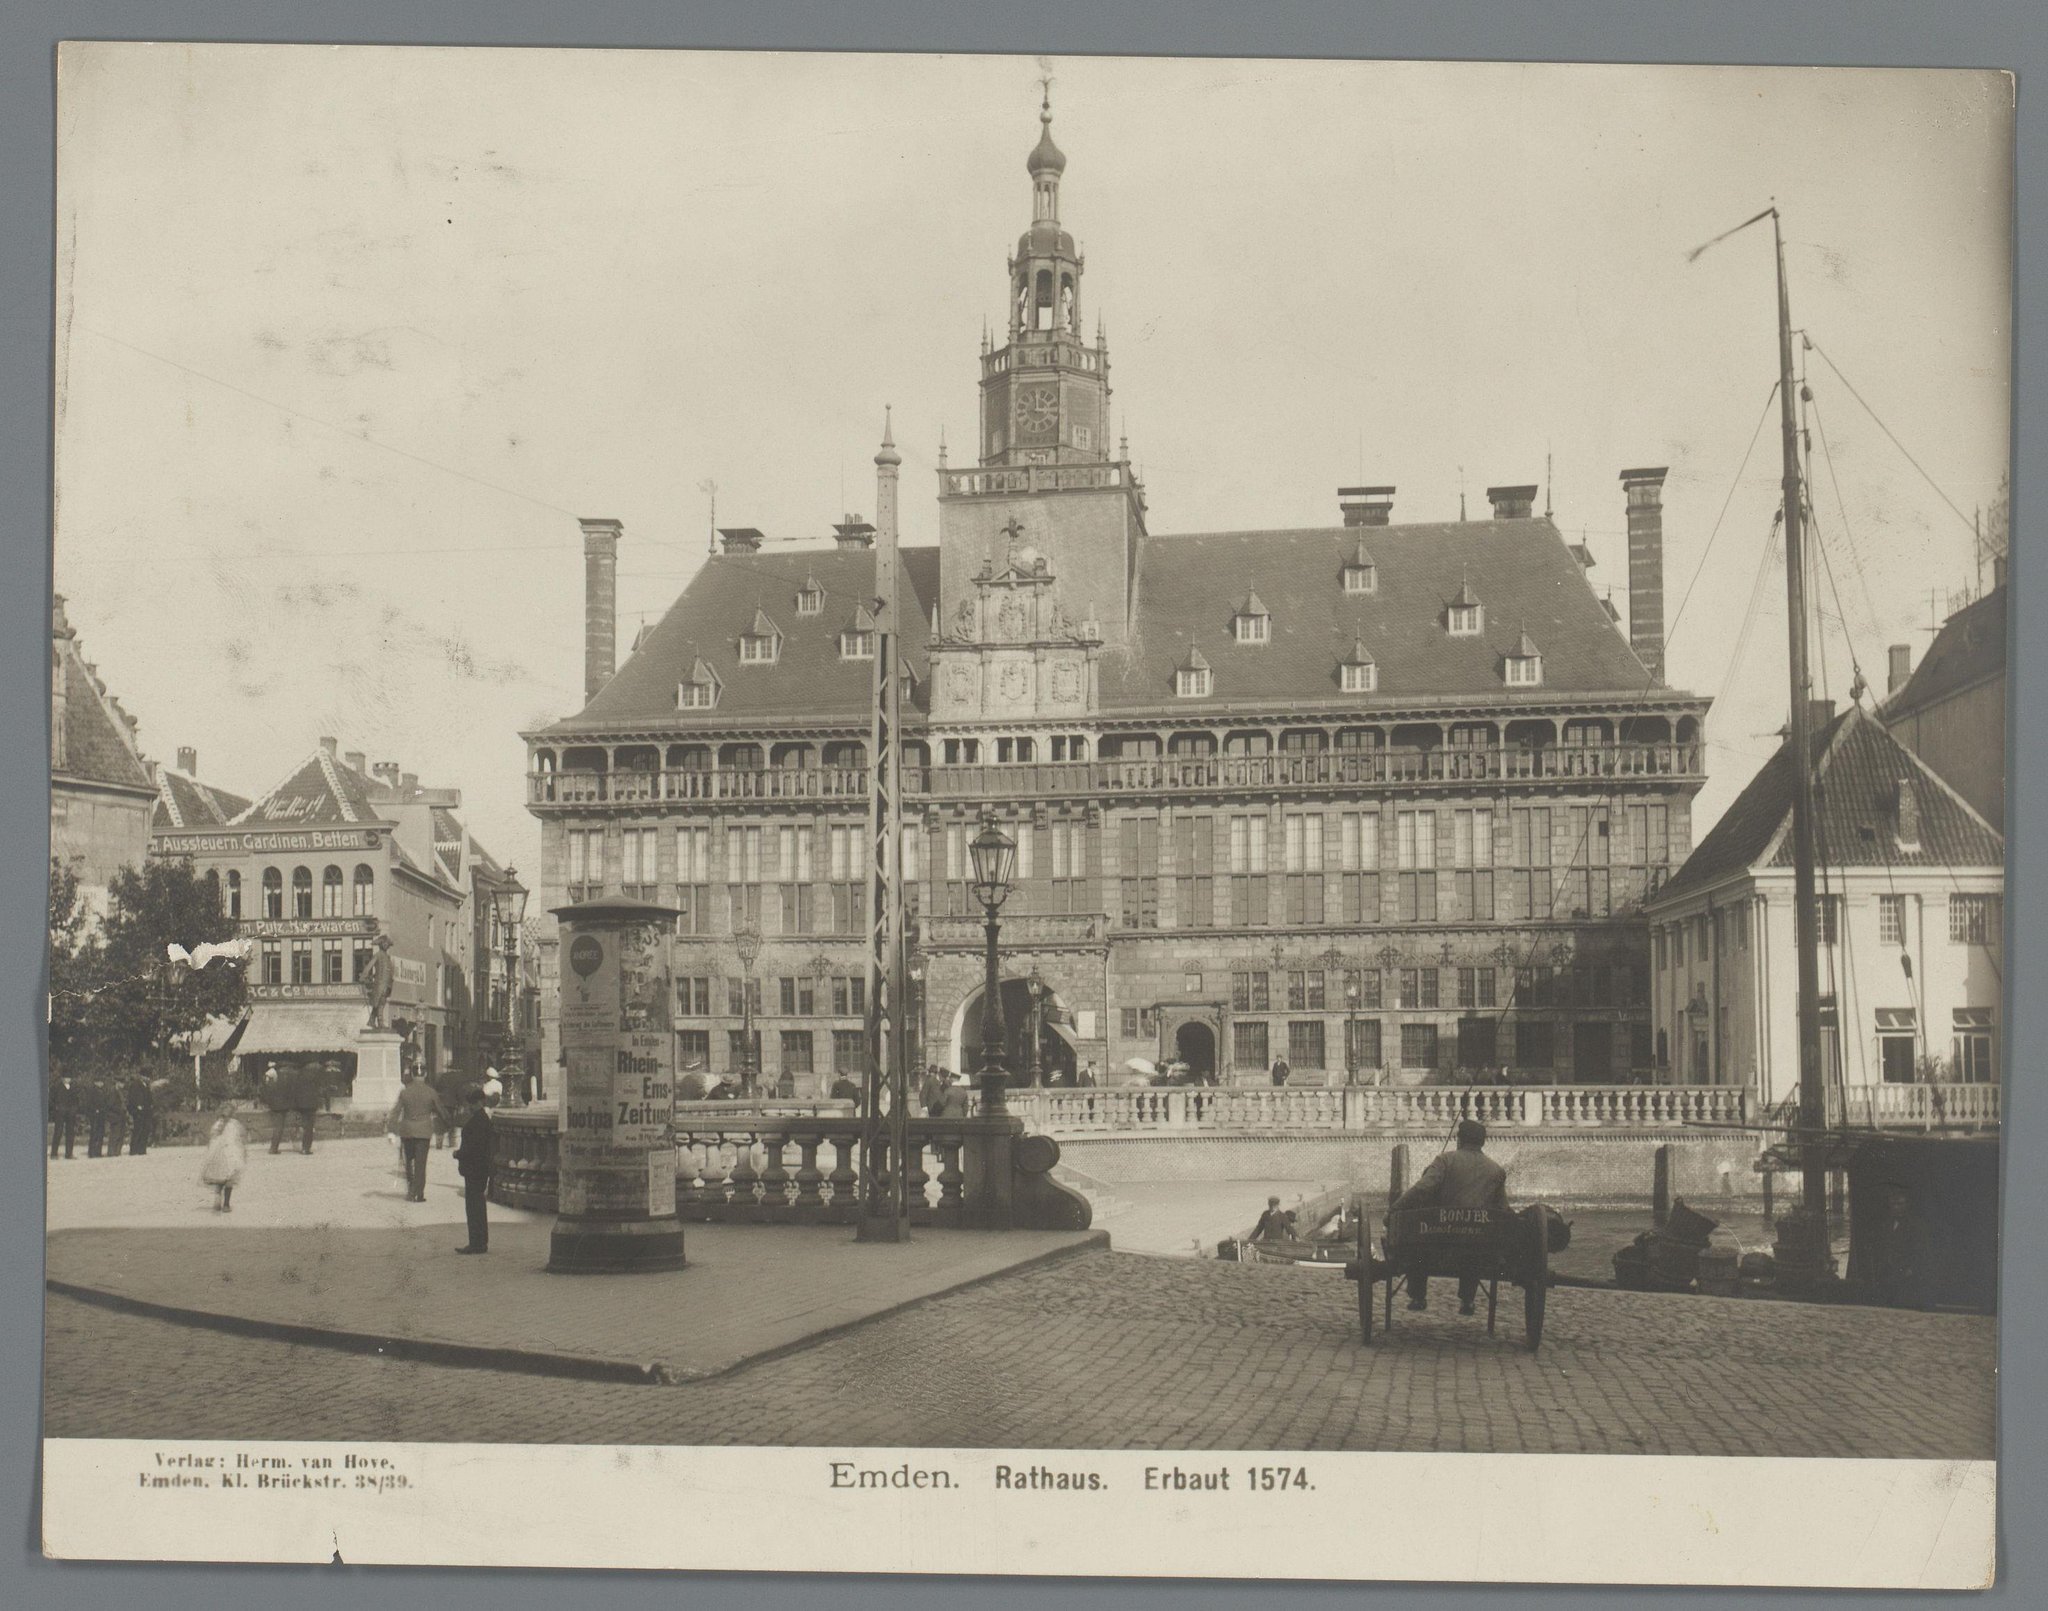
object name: photograph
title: Emden. Rathaus. Erbaut 1574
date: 1919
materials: paper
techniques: gelatin silver print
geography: emden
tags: townhall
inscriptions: inscription: ‘Verlag: Herm. van Hove./ Emden, Kl. Brückstr. 38/39.’, collector's mark: Lugt 2228